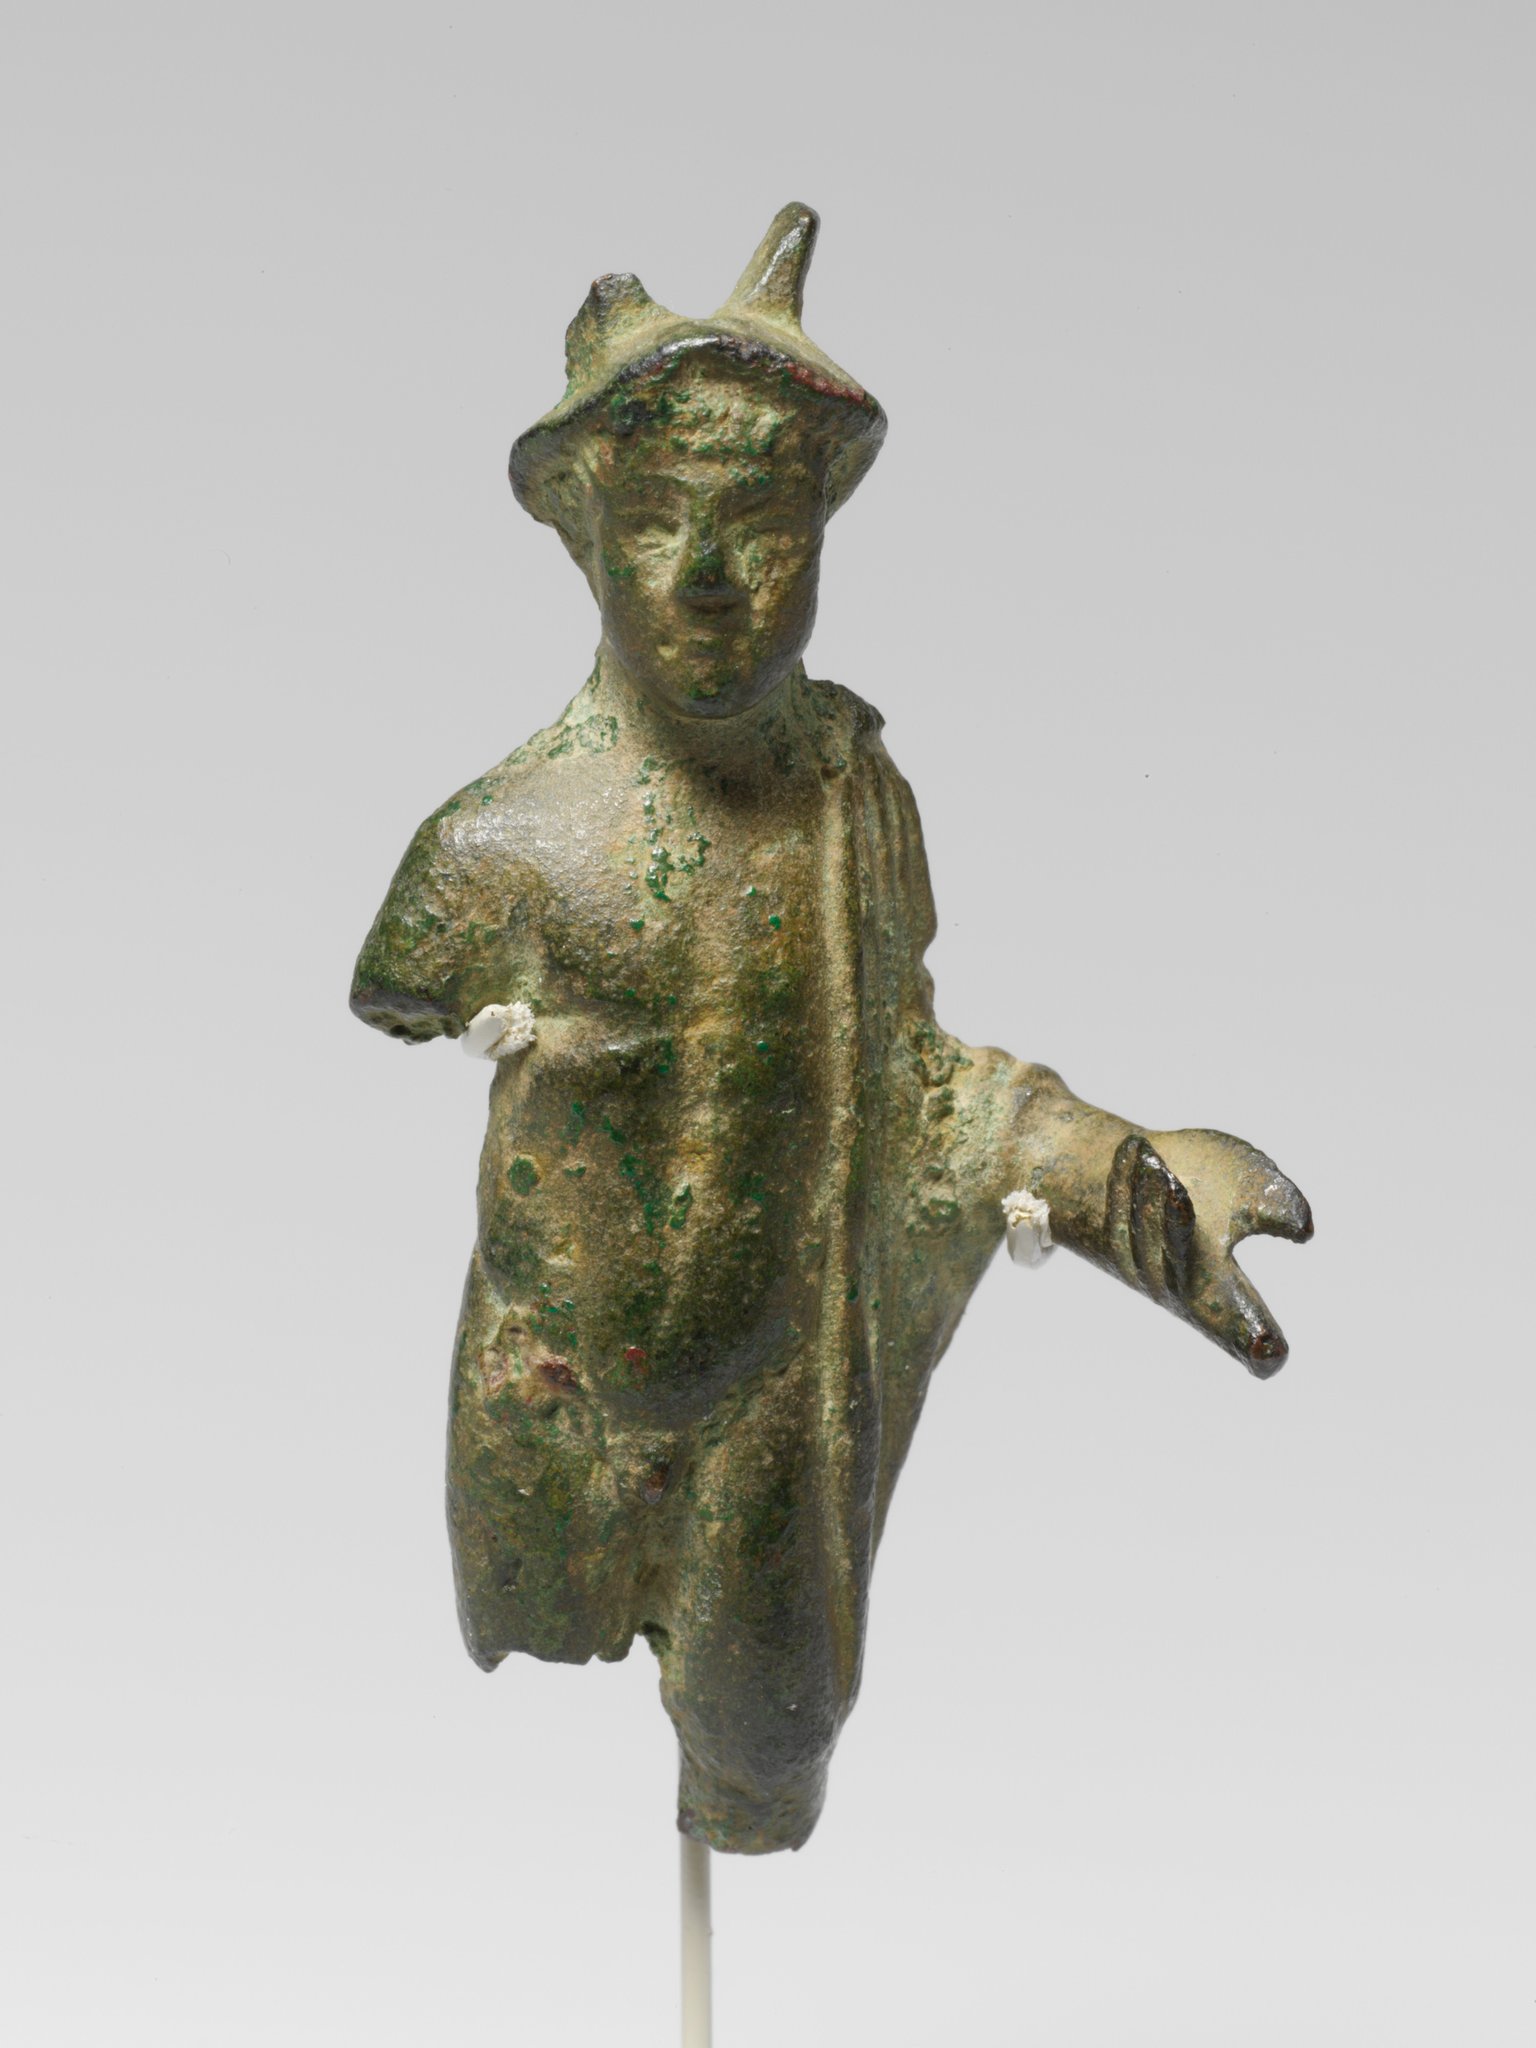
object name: statuette of hermes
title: Bronze statuette of Mercury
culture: roman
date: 1-200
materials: bronze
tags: mercury